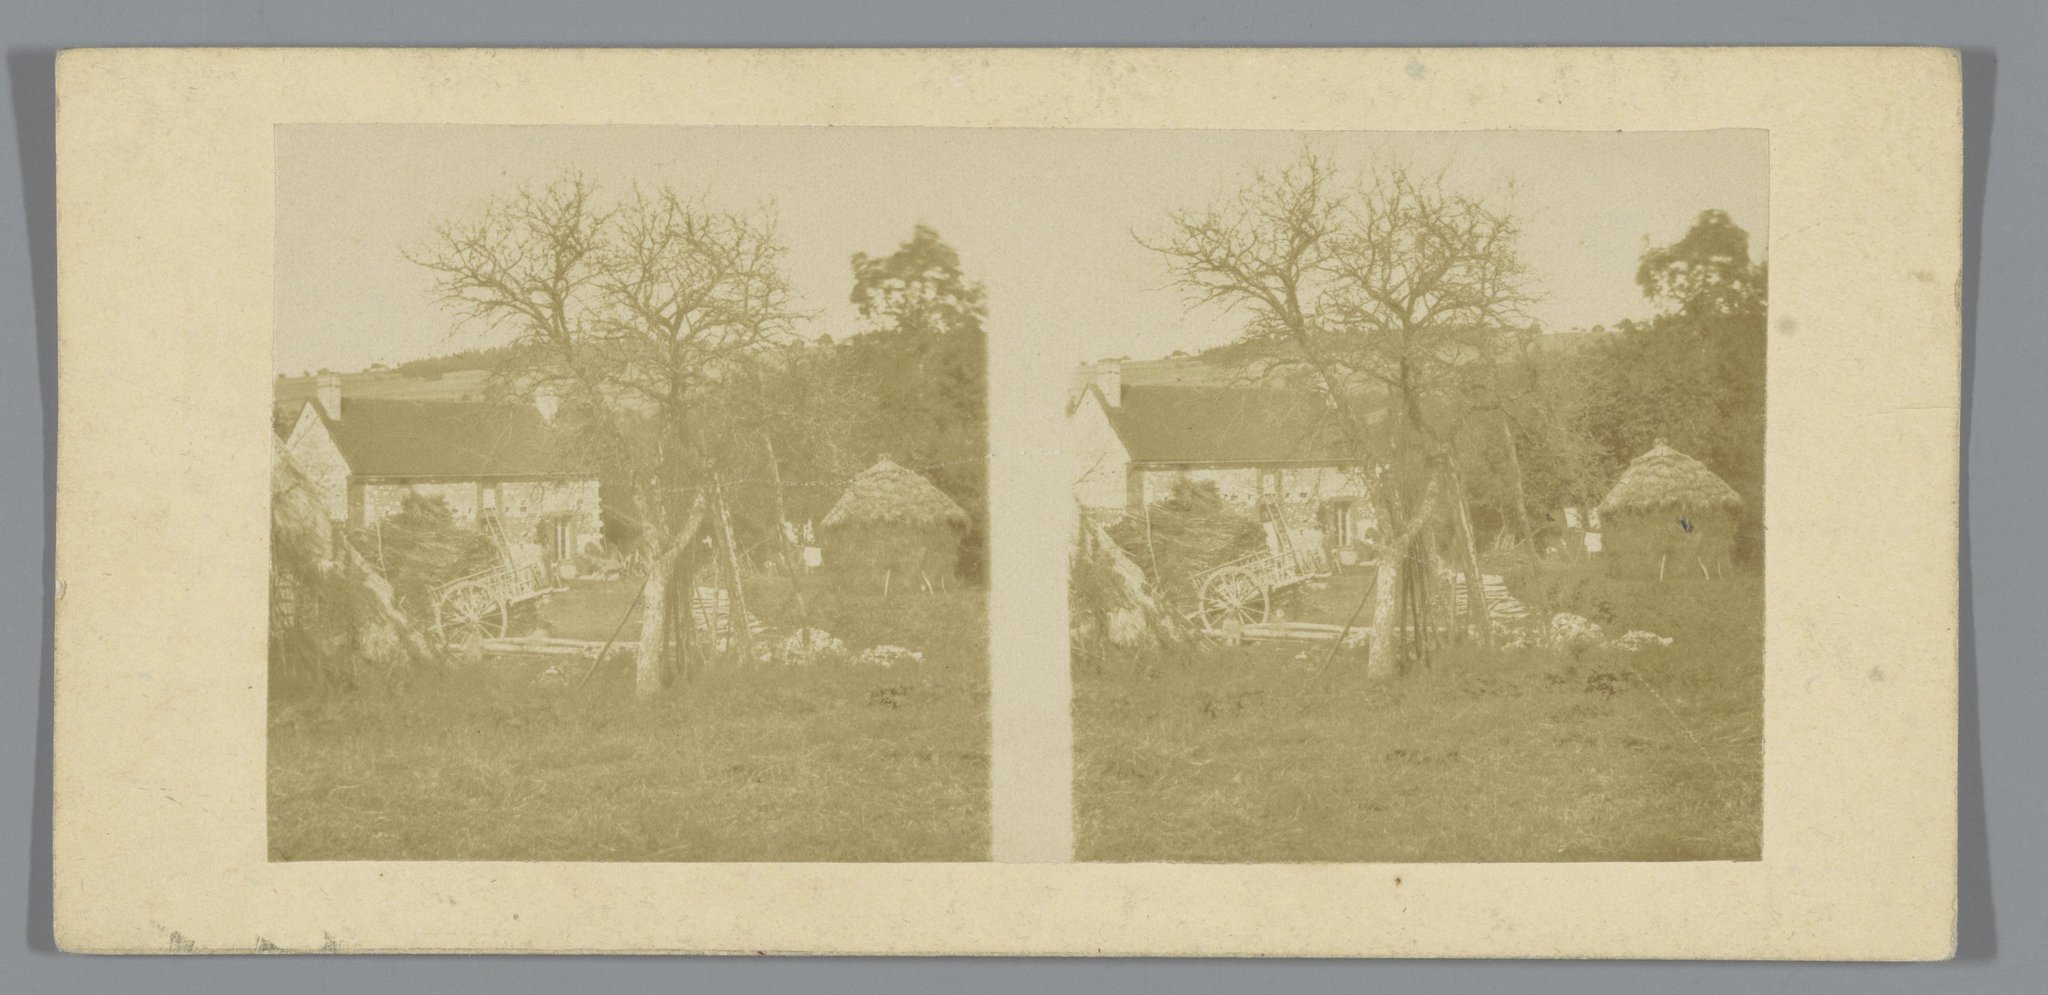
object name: stereograph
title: Exterieur van een woning te Bourgogne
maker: Anonymous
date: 1860-1880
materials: cardboard, photographic support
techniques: albumen print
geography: burgundy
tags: housing, façade (of house or building)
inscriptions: inscription: ‘Paysage en Bourgogne’